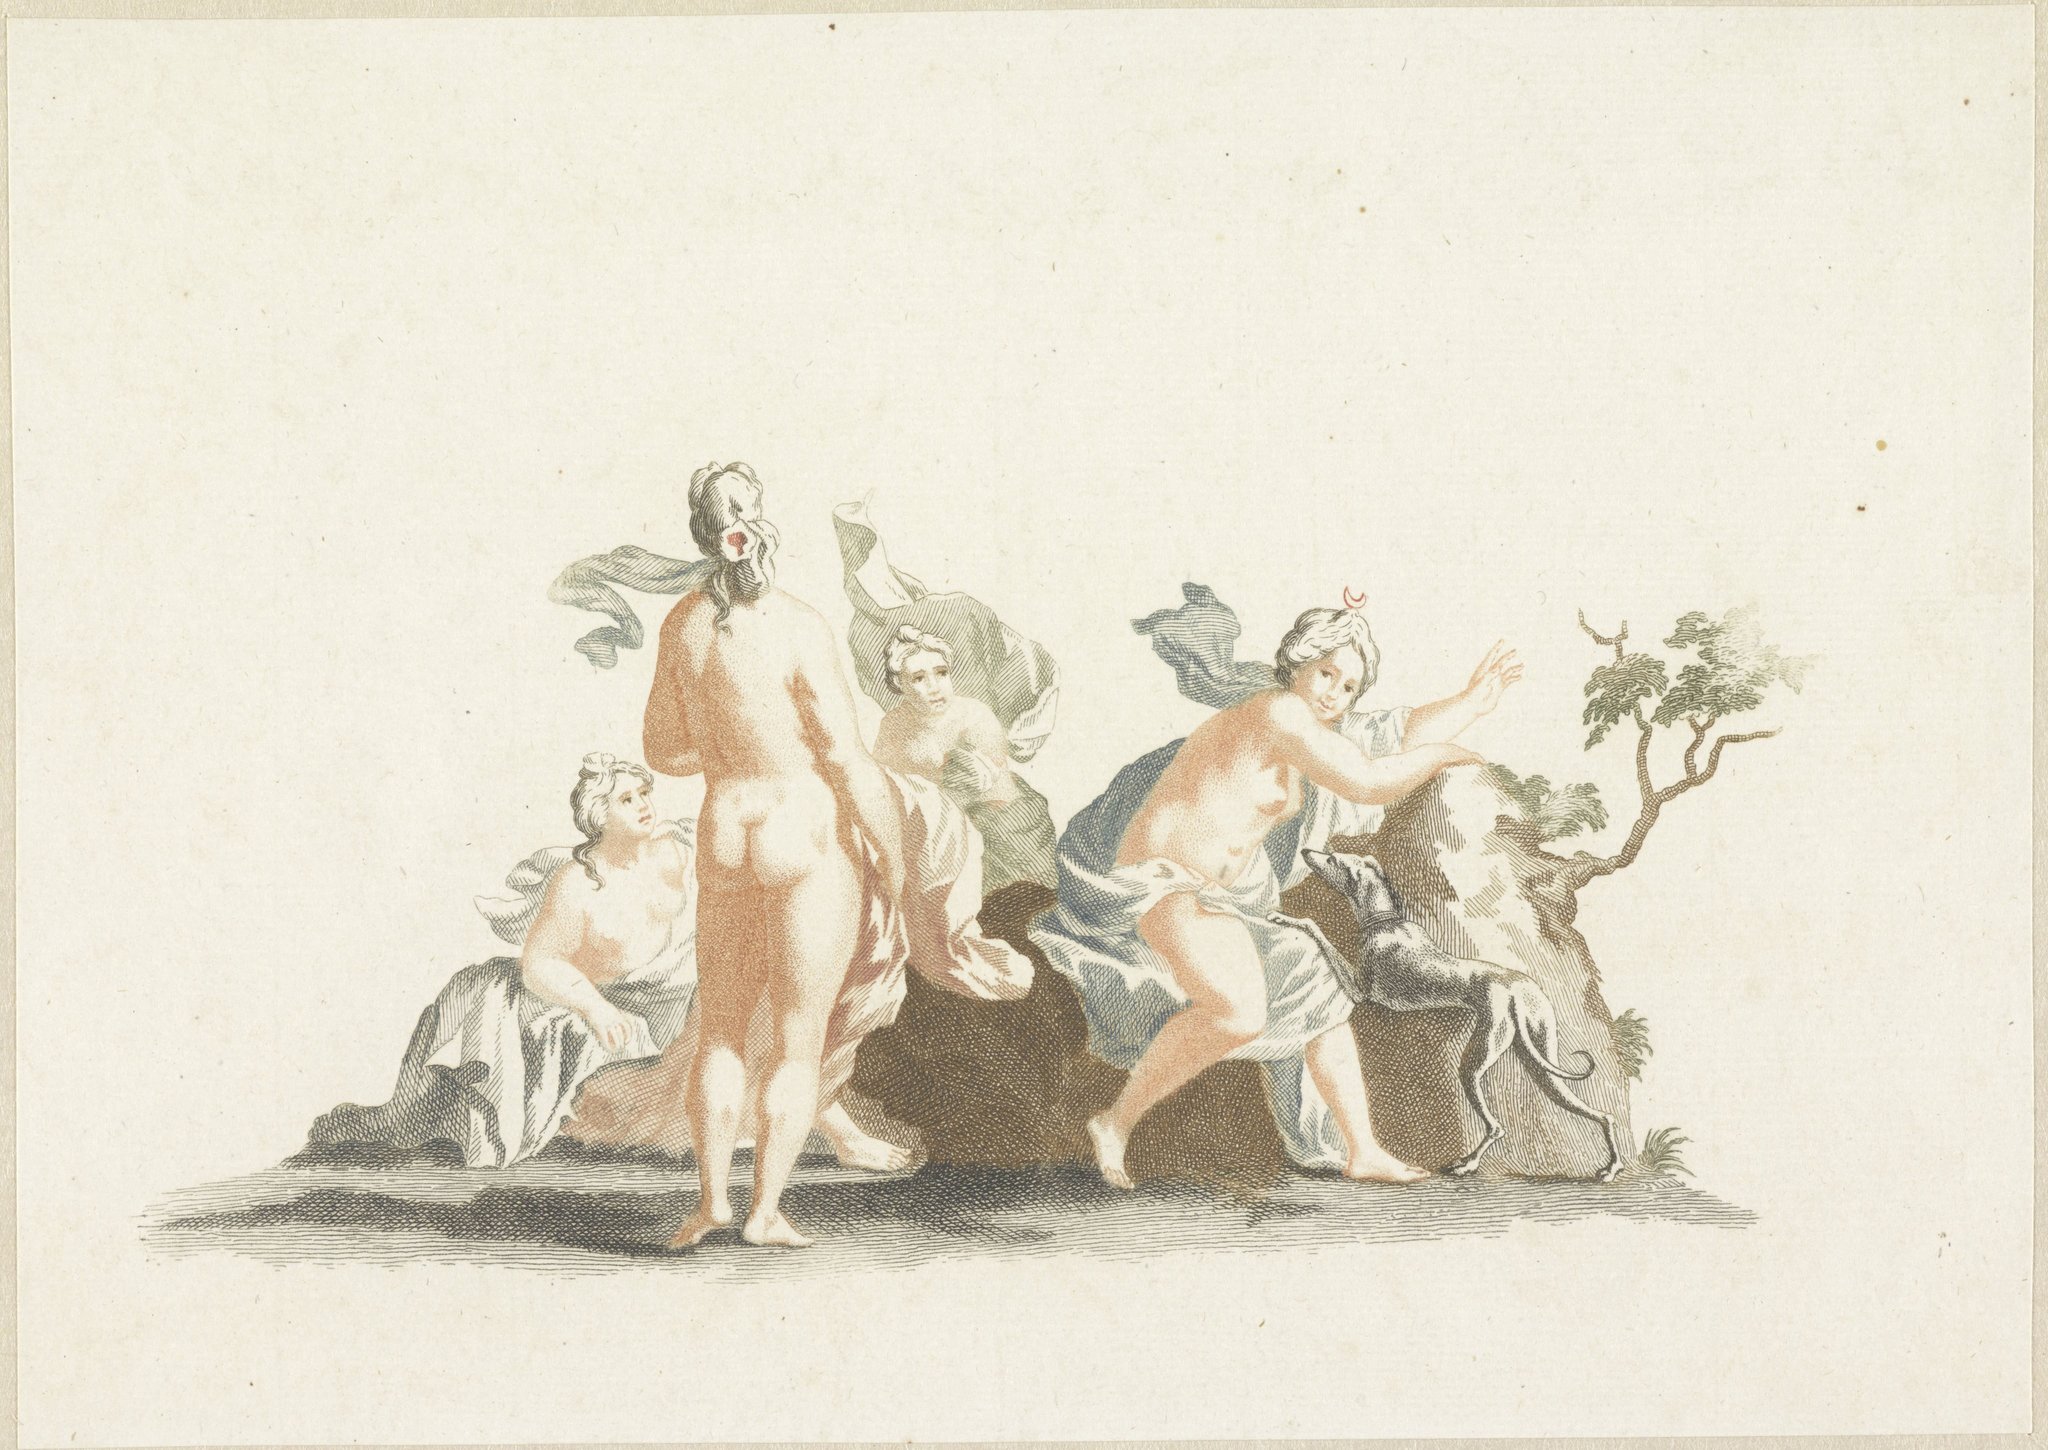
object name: print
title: Diana en haar nimfen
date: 1688-1698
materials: paper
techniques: printing, engraving, lithography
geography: netherlands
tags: companions, nymphs of diana; 'ninfe di diana' (ripa), (story of) diana (artemis)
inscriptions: collector's mark: Lugt 2228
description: Diana, maangodin en godin van de jacht, met een jachthond. Naast haar drie nimfen.